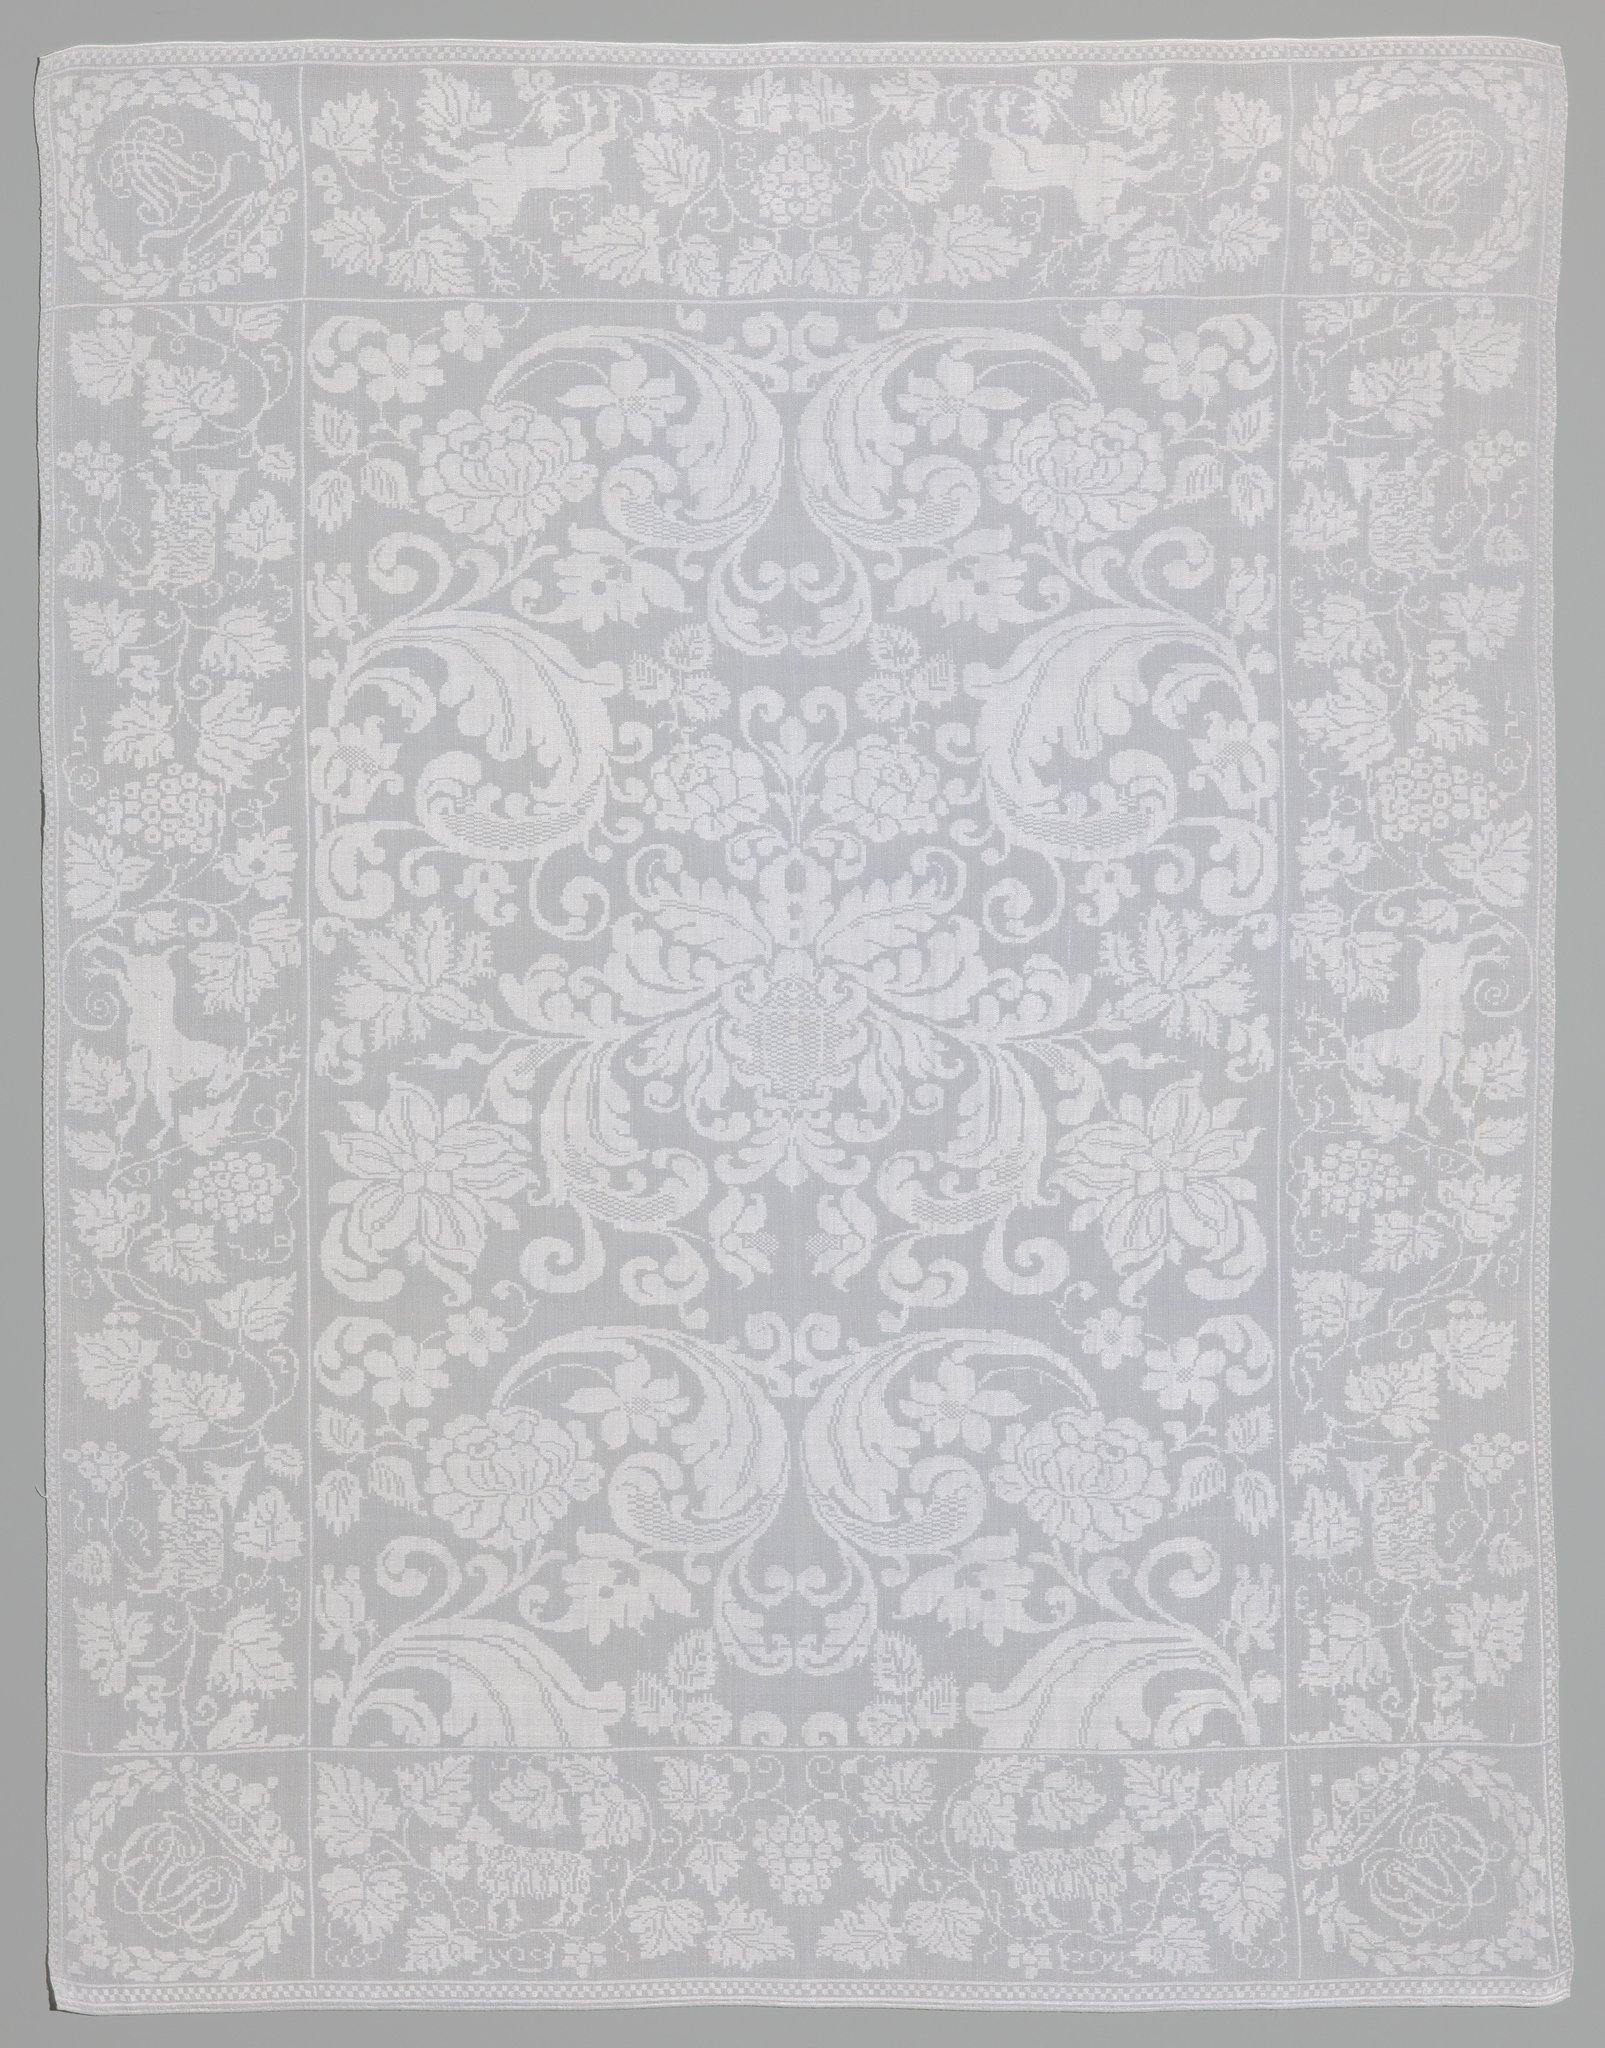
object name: napkin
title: Servet van linnendamast met een bloempatroon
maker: Anonymous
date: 1670-1690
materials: linen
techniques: damask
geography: northern netherlands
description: Servet van linnendamast met een bloempatroon. Het veld heeft bloemen en acanthusbladeren. De lopende rand heeft slingerende wijnranken. De bovenste liggende rand heeft een wijnrank en een hert, de onderste liggende rand een wijnrank en een schaap. De hoeken hebben een gekroond monogram. Bij het servet hoort een servet met invnr. BK-1979-270-B.